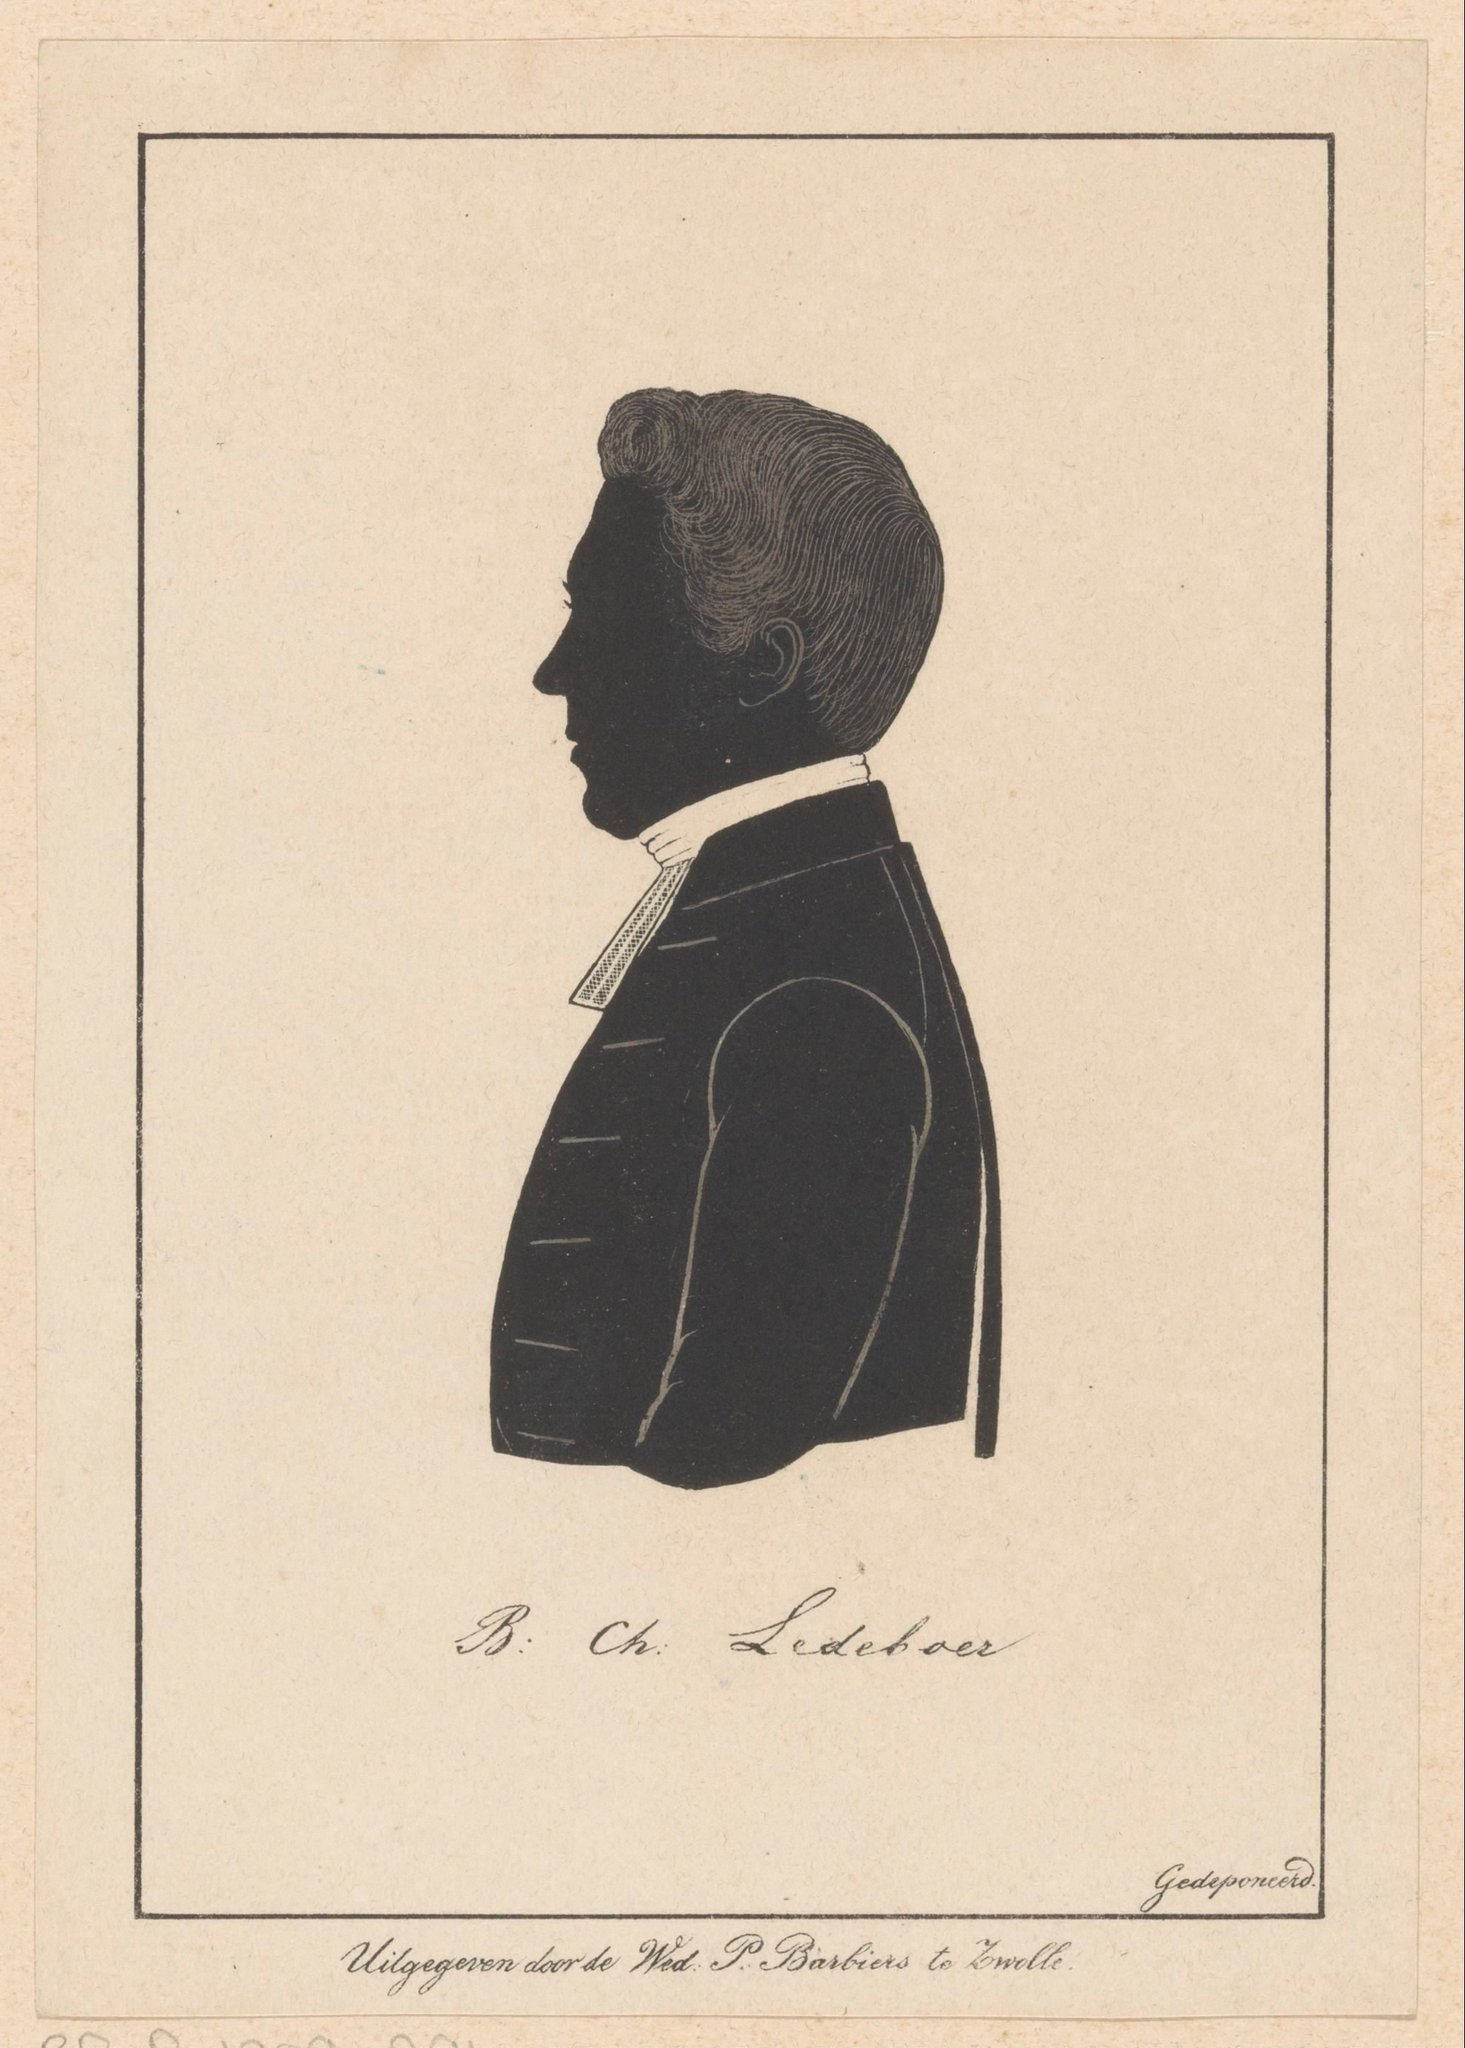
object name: print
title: Silhouetportret van B.Ch. Ledeboer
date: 1848-1862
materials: paper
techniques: hand coloring, lithograph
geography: zwolle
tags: historical persons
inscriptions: : ‘Gedeponeerd.’, collector's mark: Lugt 2228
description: Onder het portret de signatuur van de geportretteerde.